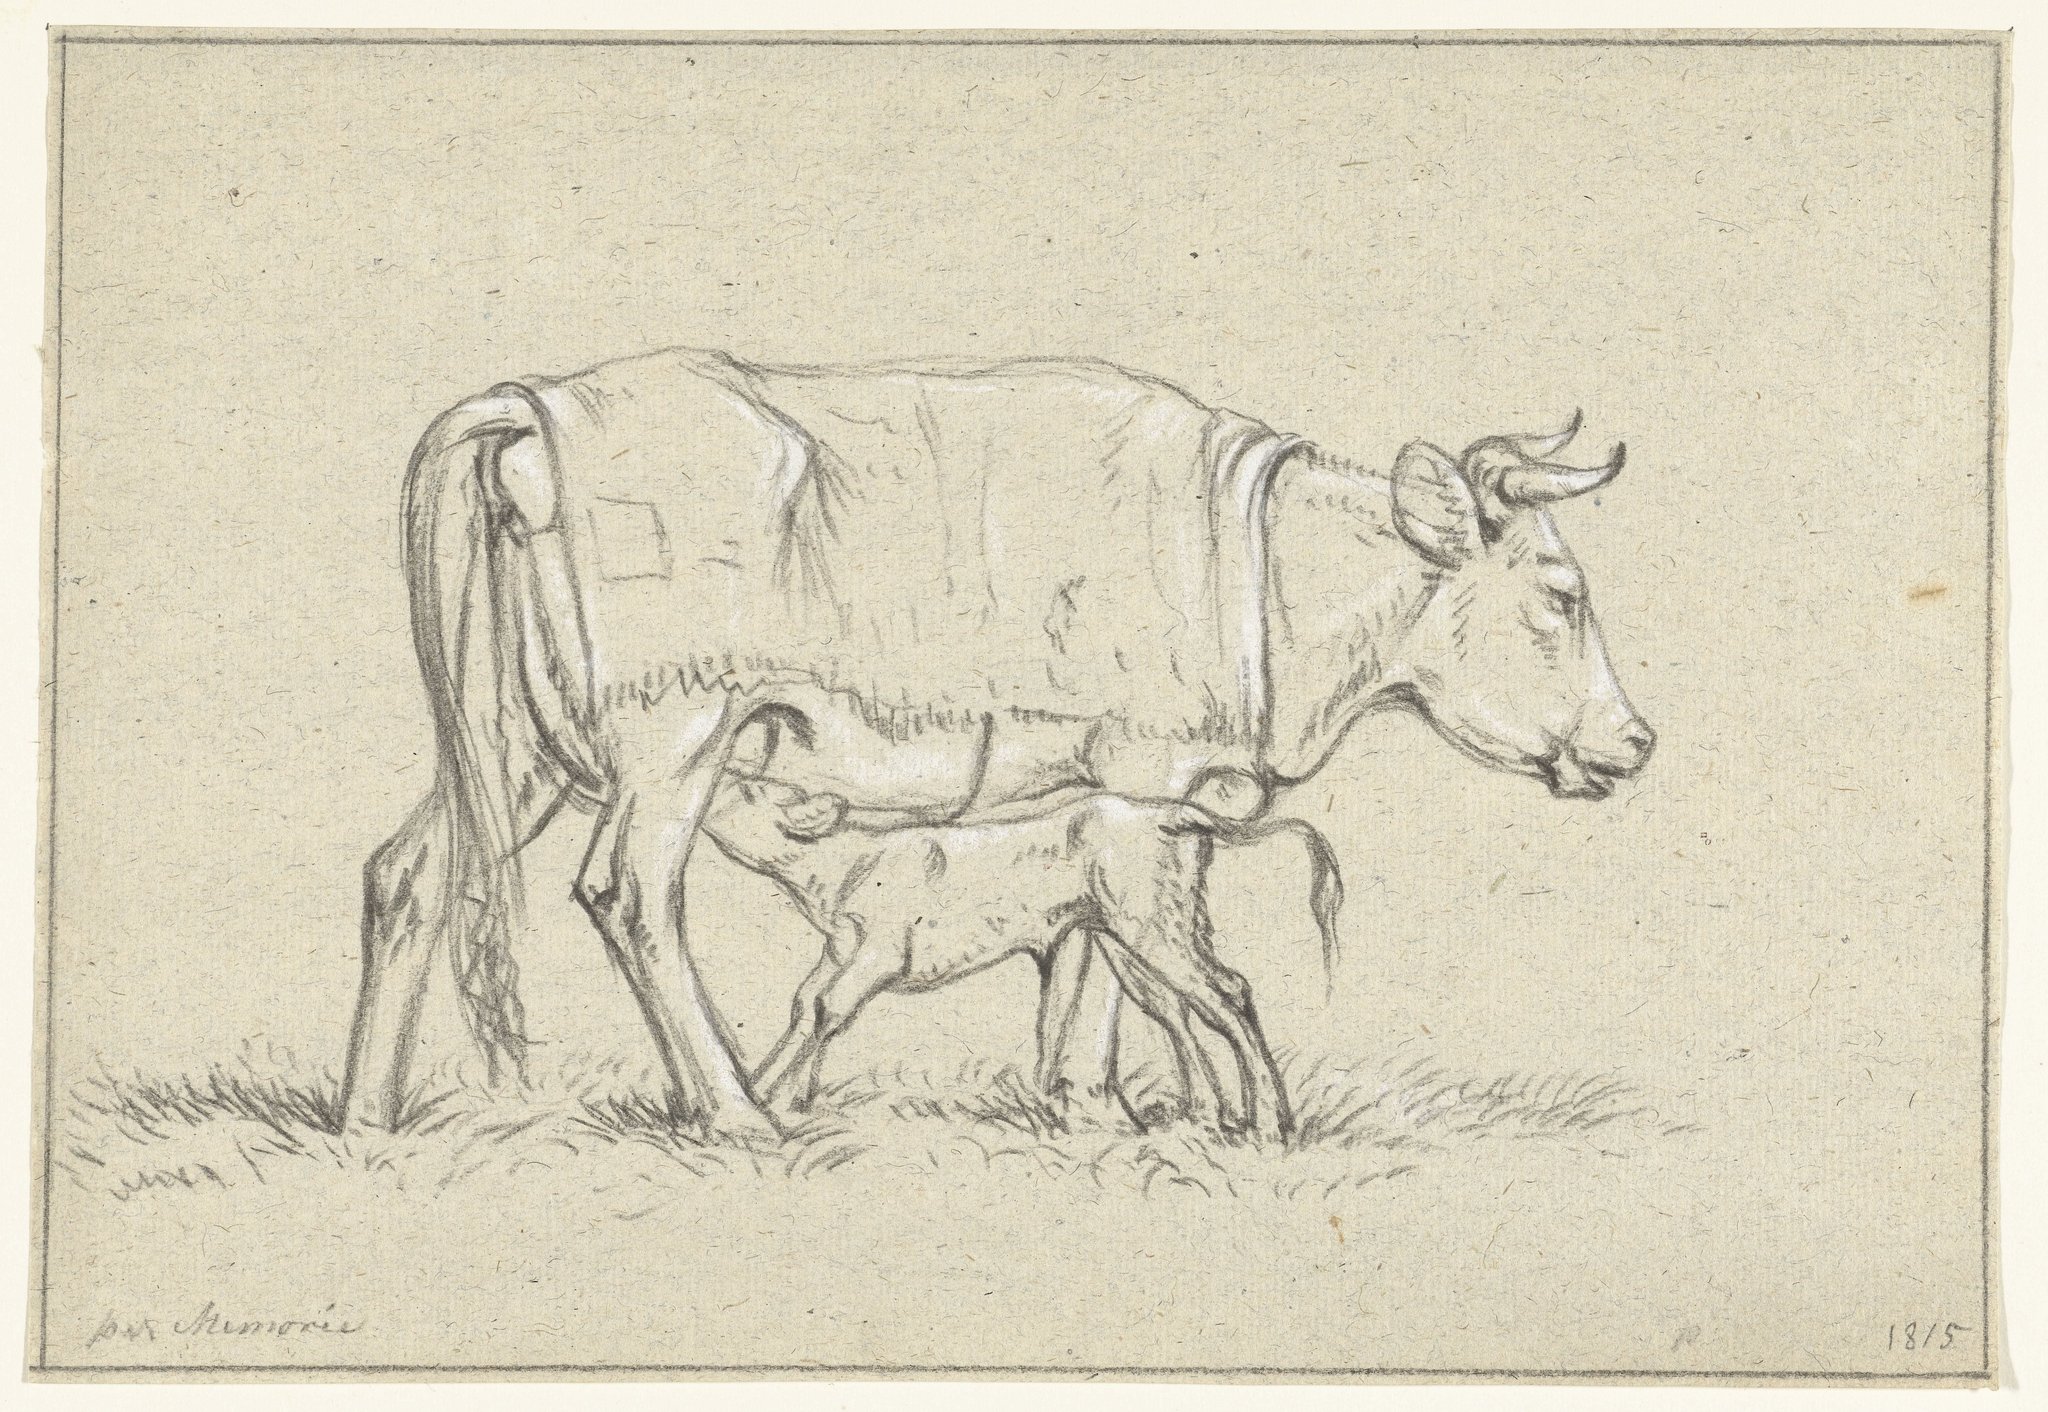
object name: drawing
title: Kalf drinkend bij zijn moeder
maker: jean bernard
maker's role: draughtsman, print maker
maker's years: 1765-1833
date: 1815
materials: chalk, paper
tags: cow, calf